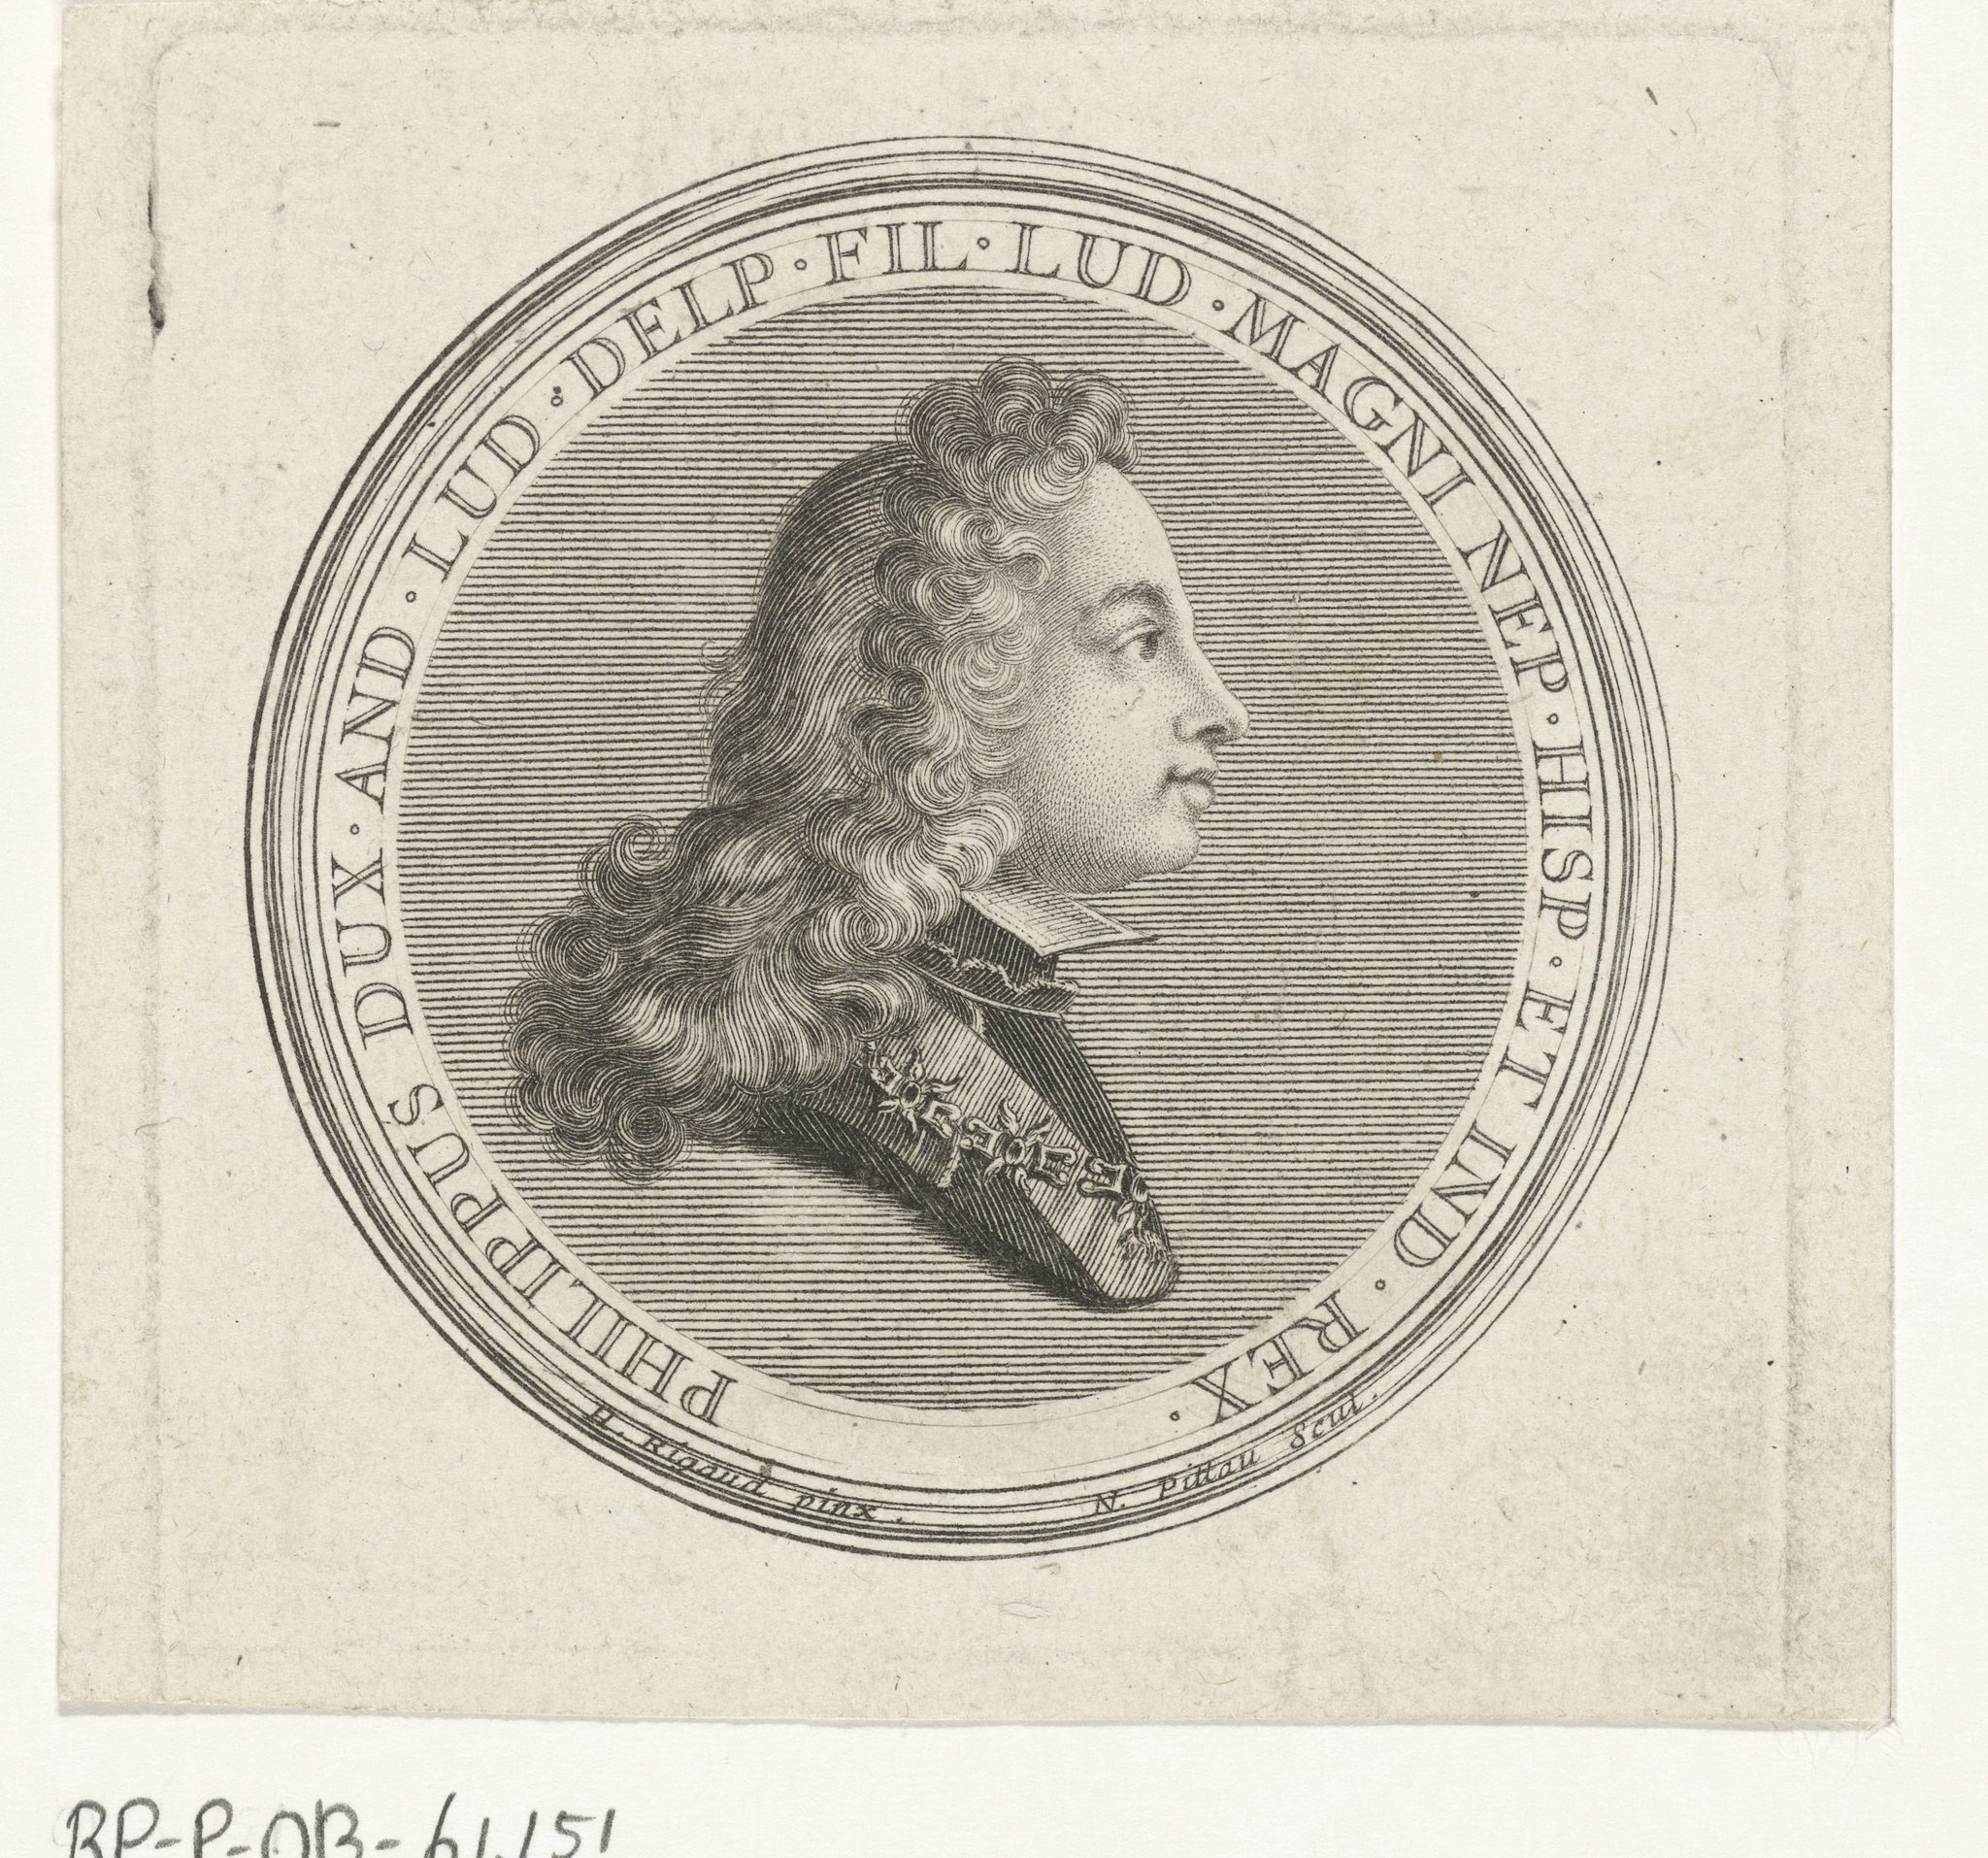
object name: print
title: Medaillon met het portret van Filips IV van Spanje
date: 1644-1671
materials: paper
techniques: engraving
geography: paris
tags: filips iv (koning van spanje), medal (considered as a piece of sculpture, regardless of its specific function), knighthood order of the golden fleece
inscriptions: collector's mark: Lugt 240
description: Medaillon met het portret van Filips IV van Spanje. Hij draagt een keten met de Orde van het Gulden Vlies.